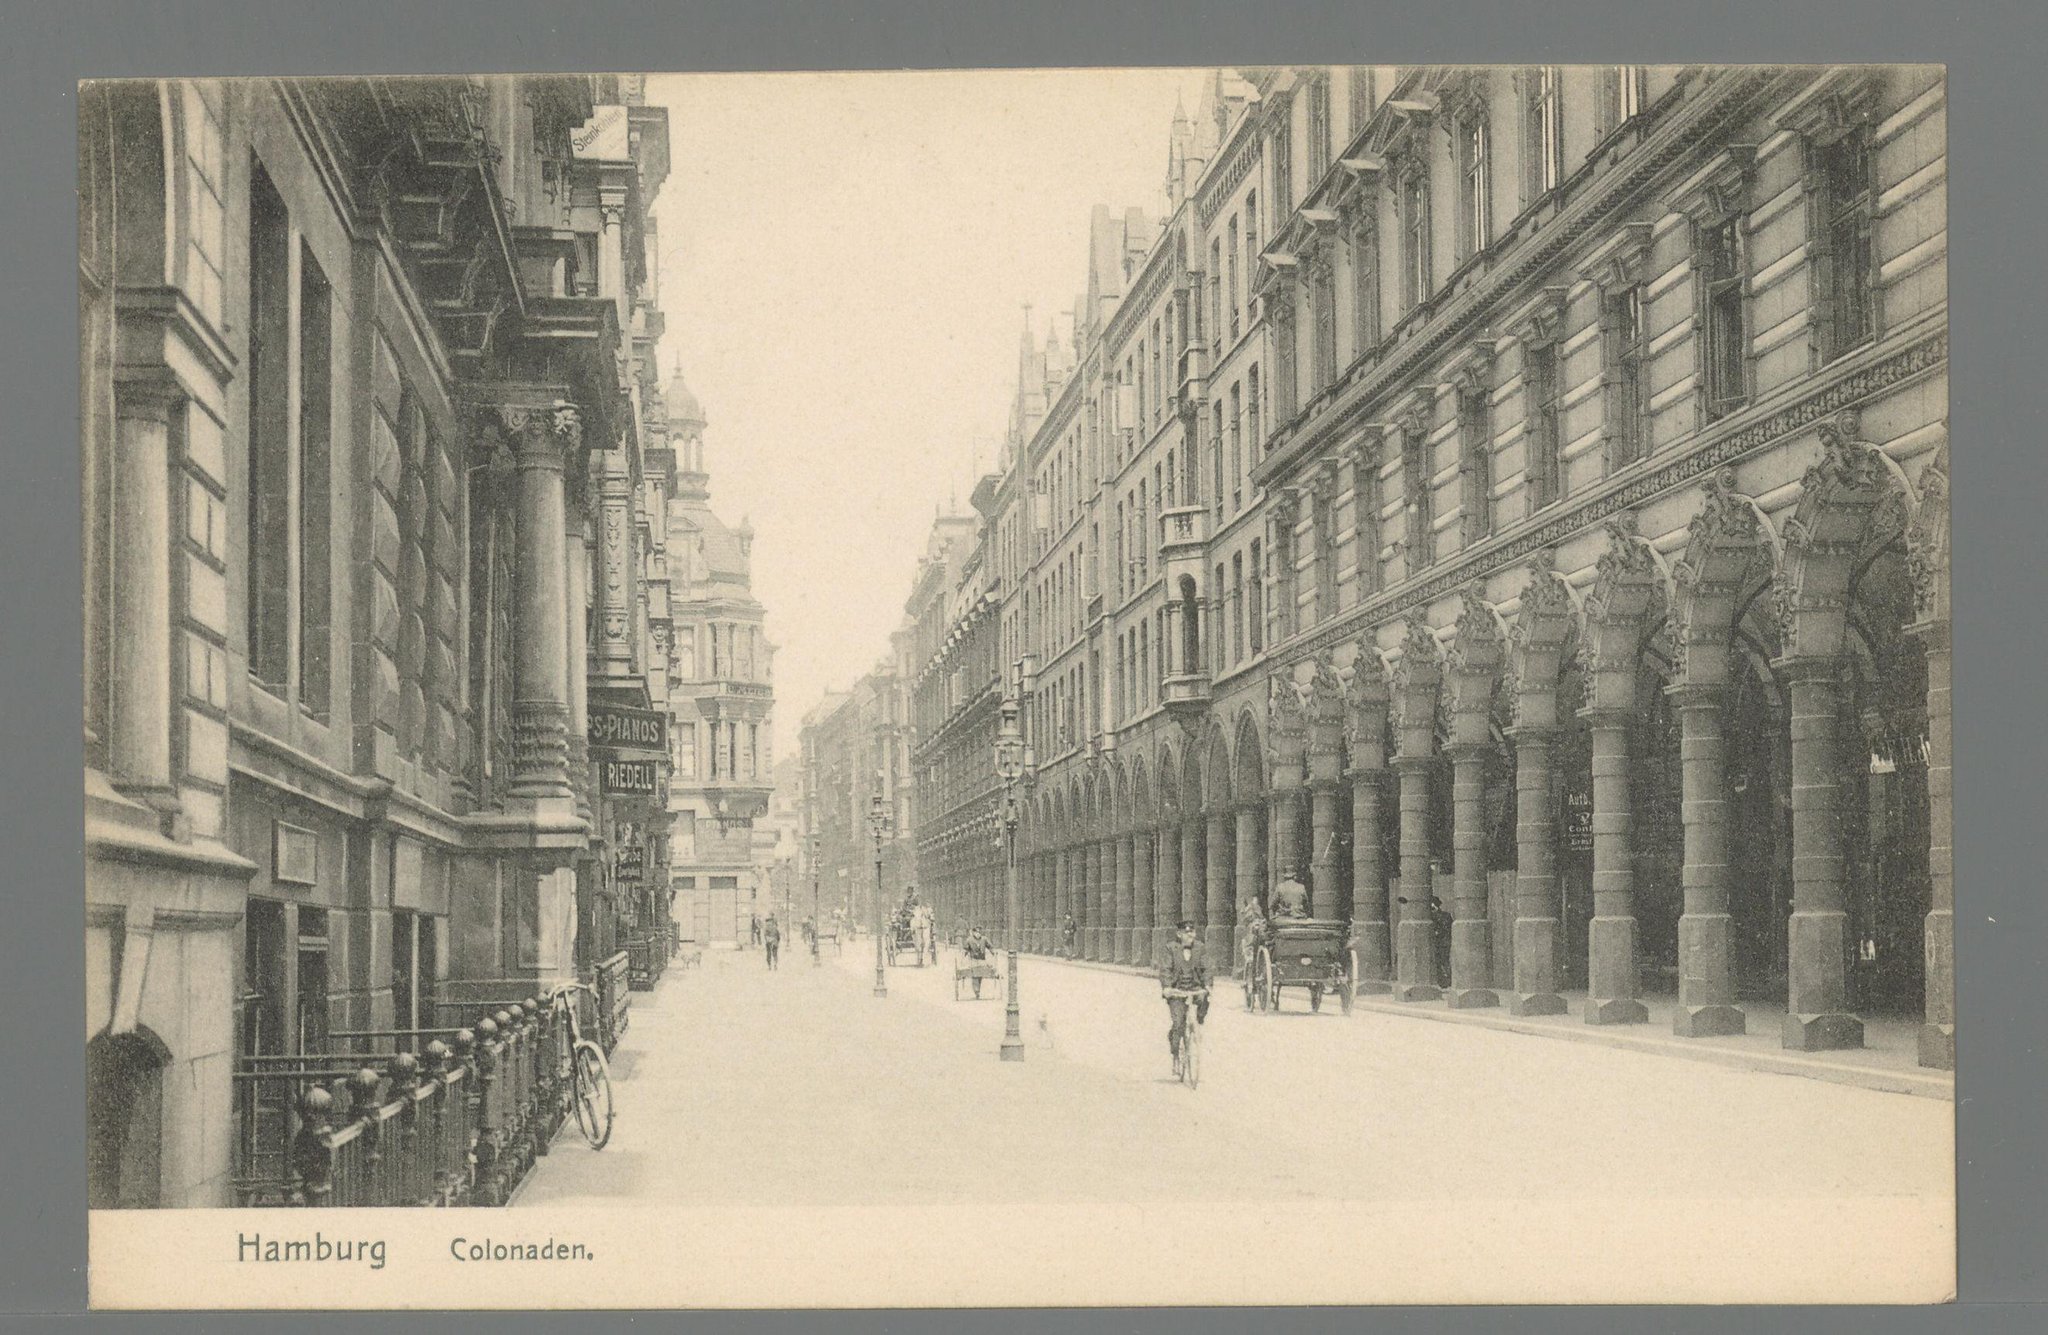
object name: ansichtkaart, prentbriefkaart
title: Hamburg. Colonaden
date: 1905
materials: cardboard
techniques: photograph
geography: hamburg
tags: street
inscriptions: date